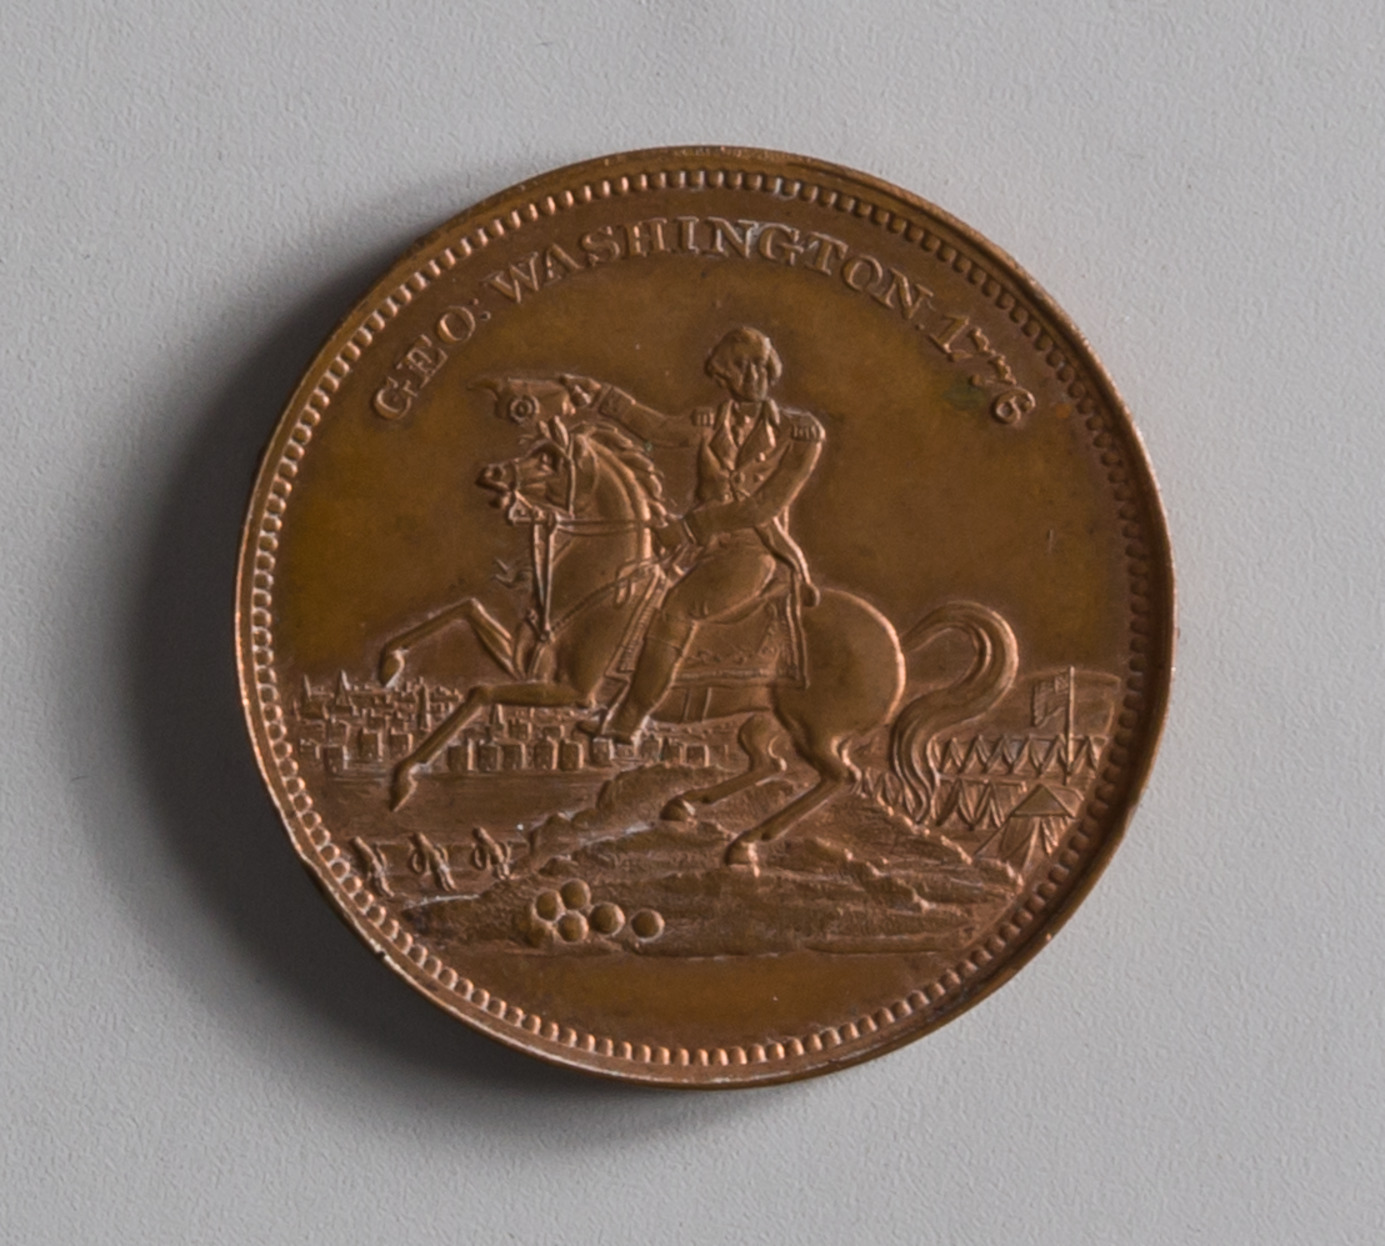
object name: medal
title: George Washington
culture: american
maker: robert lovett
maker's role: maker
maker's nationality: american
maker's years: 1800-1830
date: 1800-1830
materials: gilt bronze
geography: mid-atlantic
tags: george washington,horses